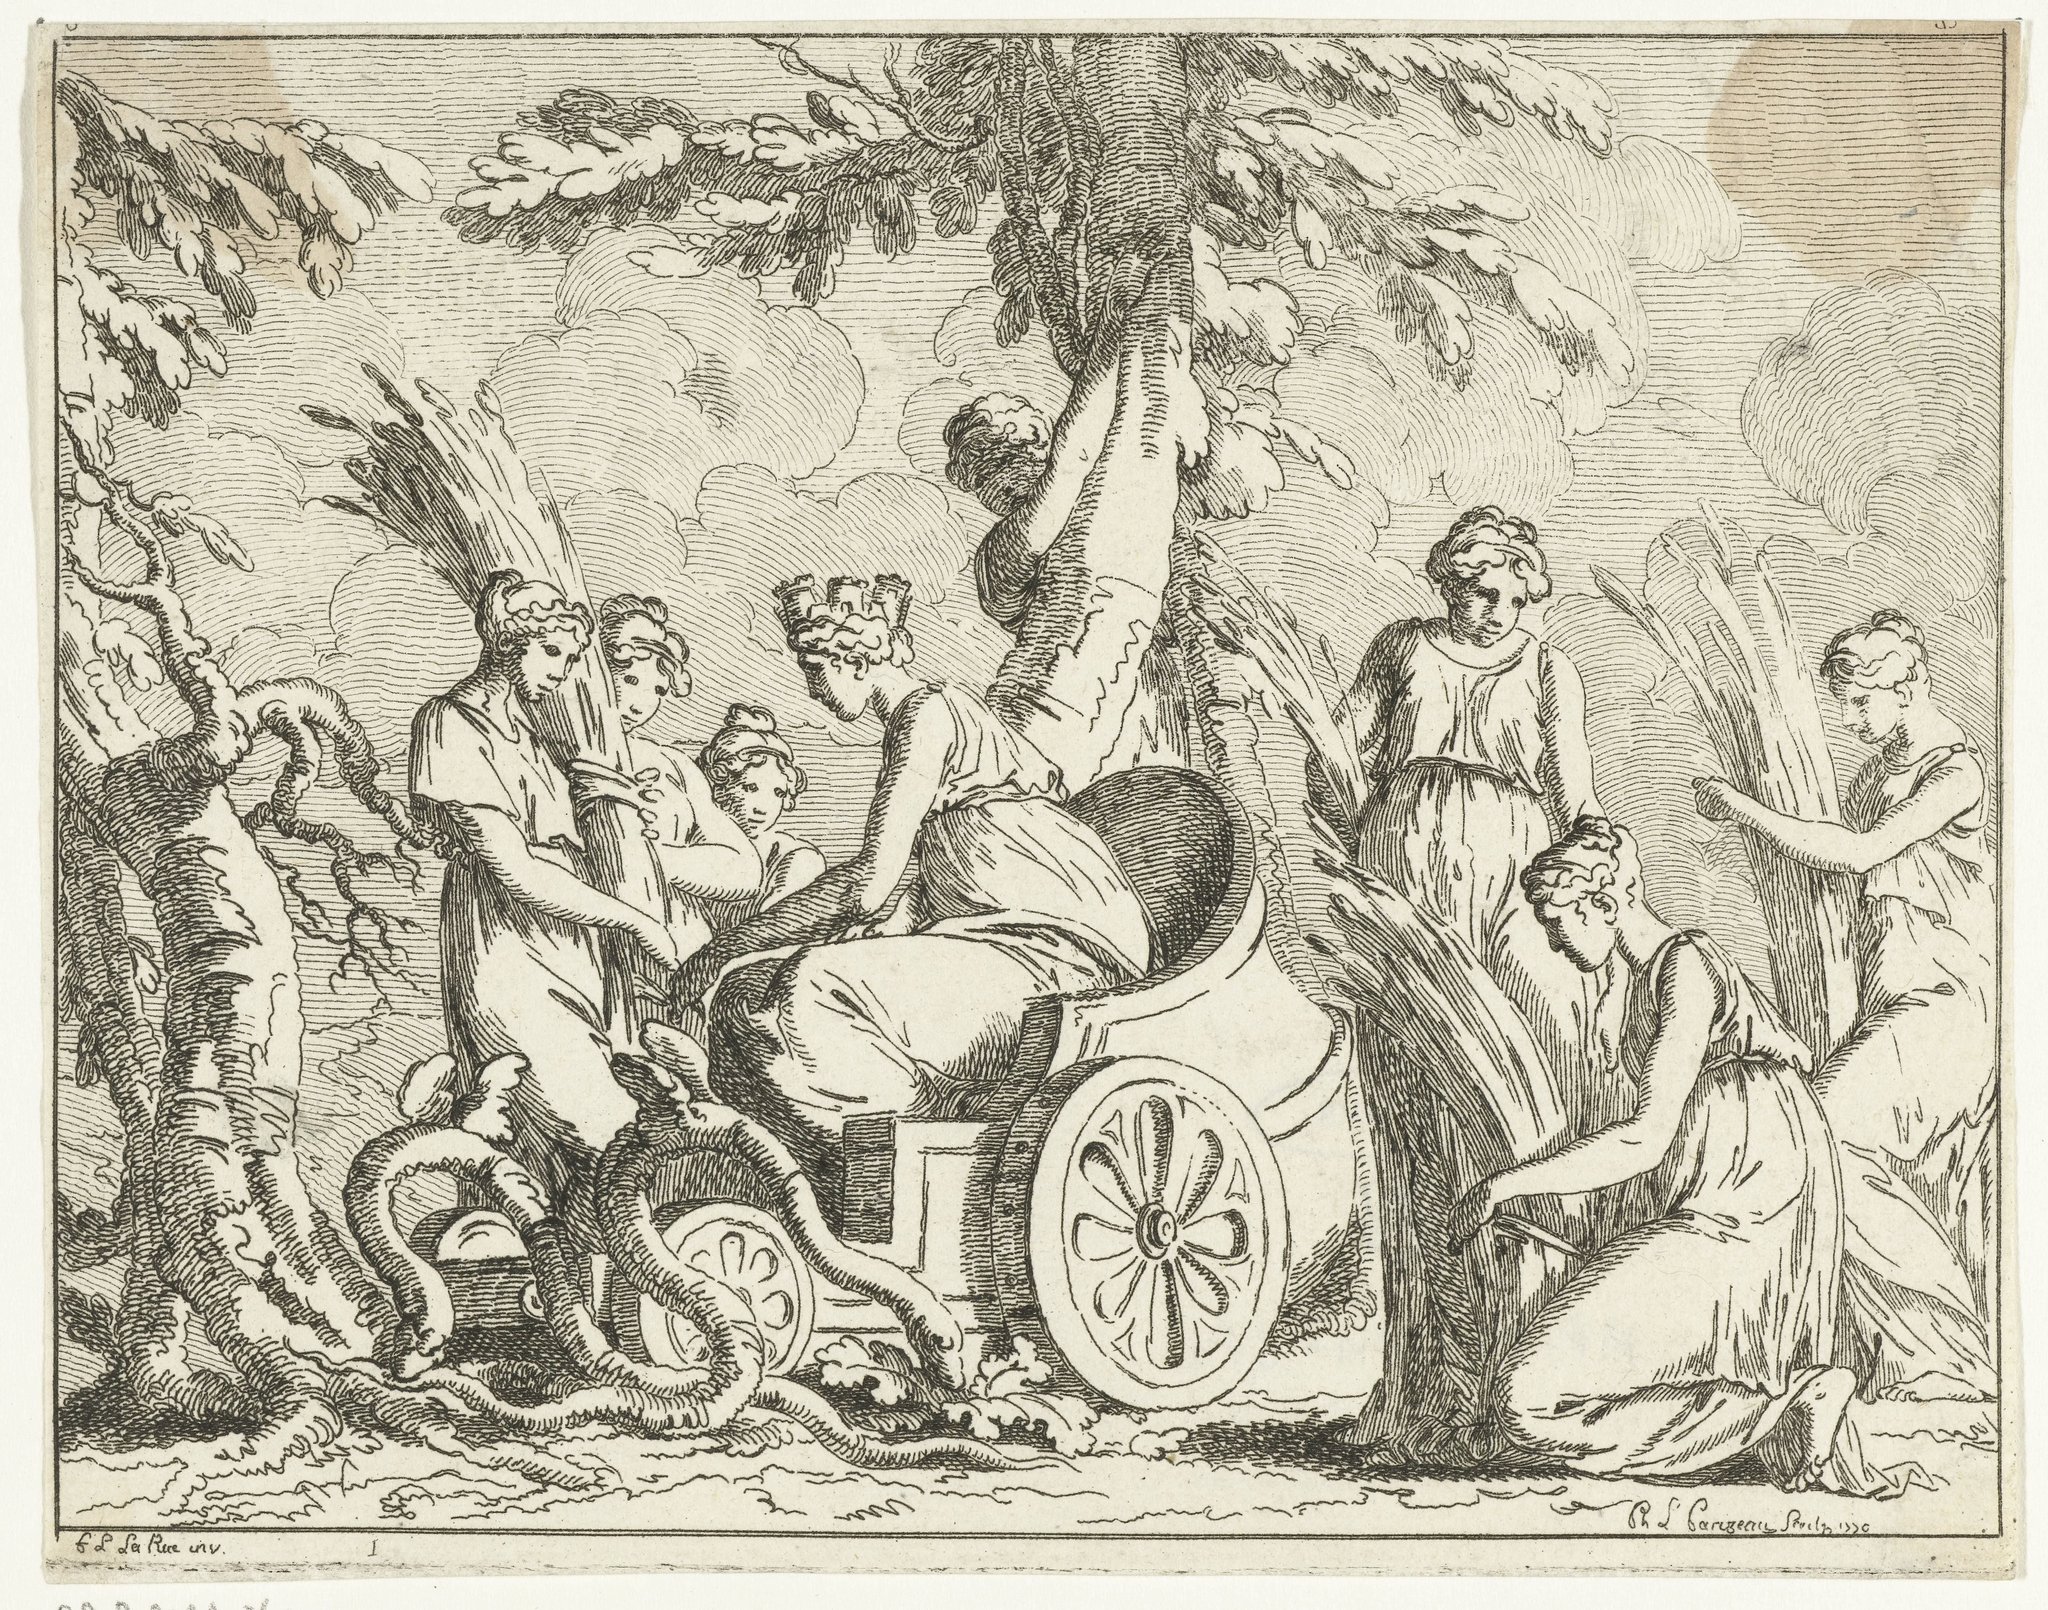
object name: print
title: Historische en mythologische scènes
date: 1770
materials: paper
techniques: etching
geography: france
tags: ceres, patroness of agriculture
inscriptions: collector's mark: Lugt 2228, collector's mark: Lugt 2760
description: Ceres in een zegewagen getrokken door twee gevleugelde slangen, omgeven door nimfen van het veld die bossen korenaren verzamelen.